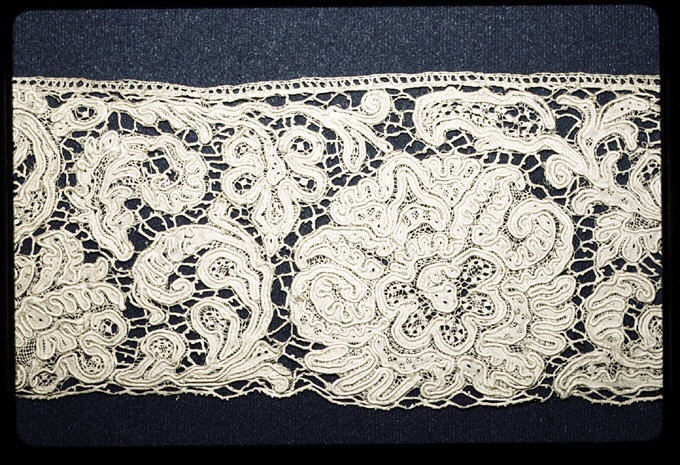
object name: edging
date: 1701-1800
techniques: embroidery